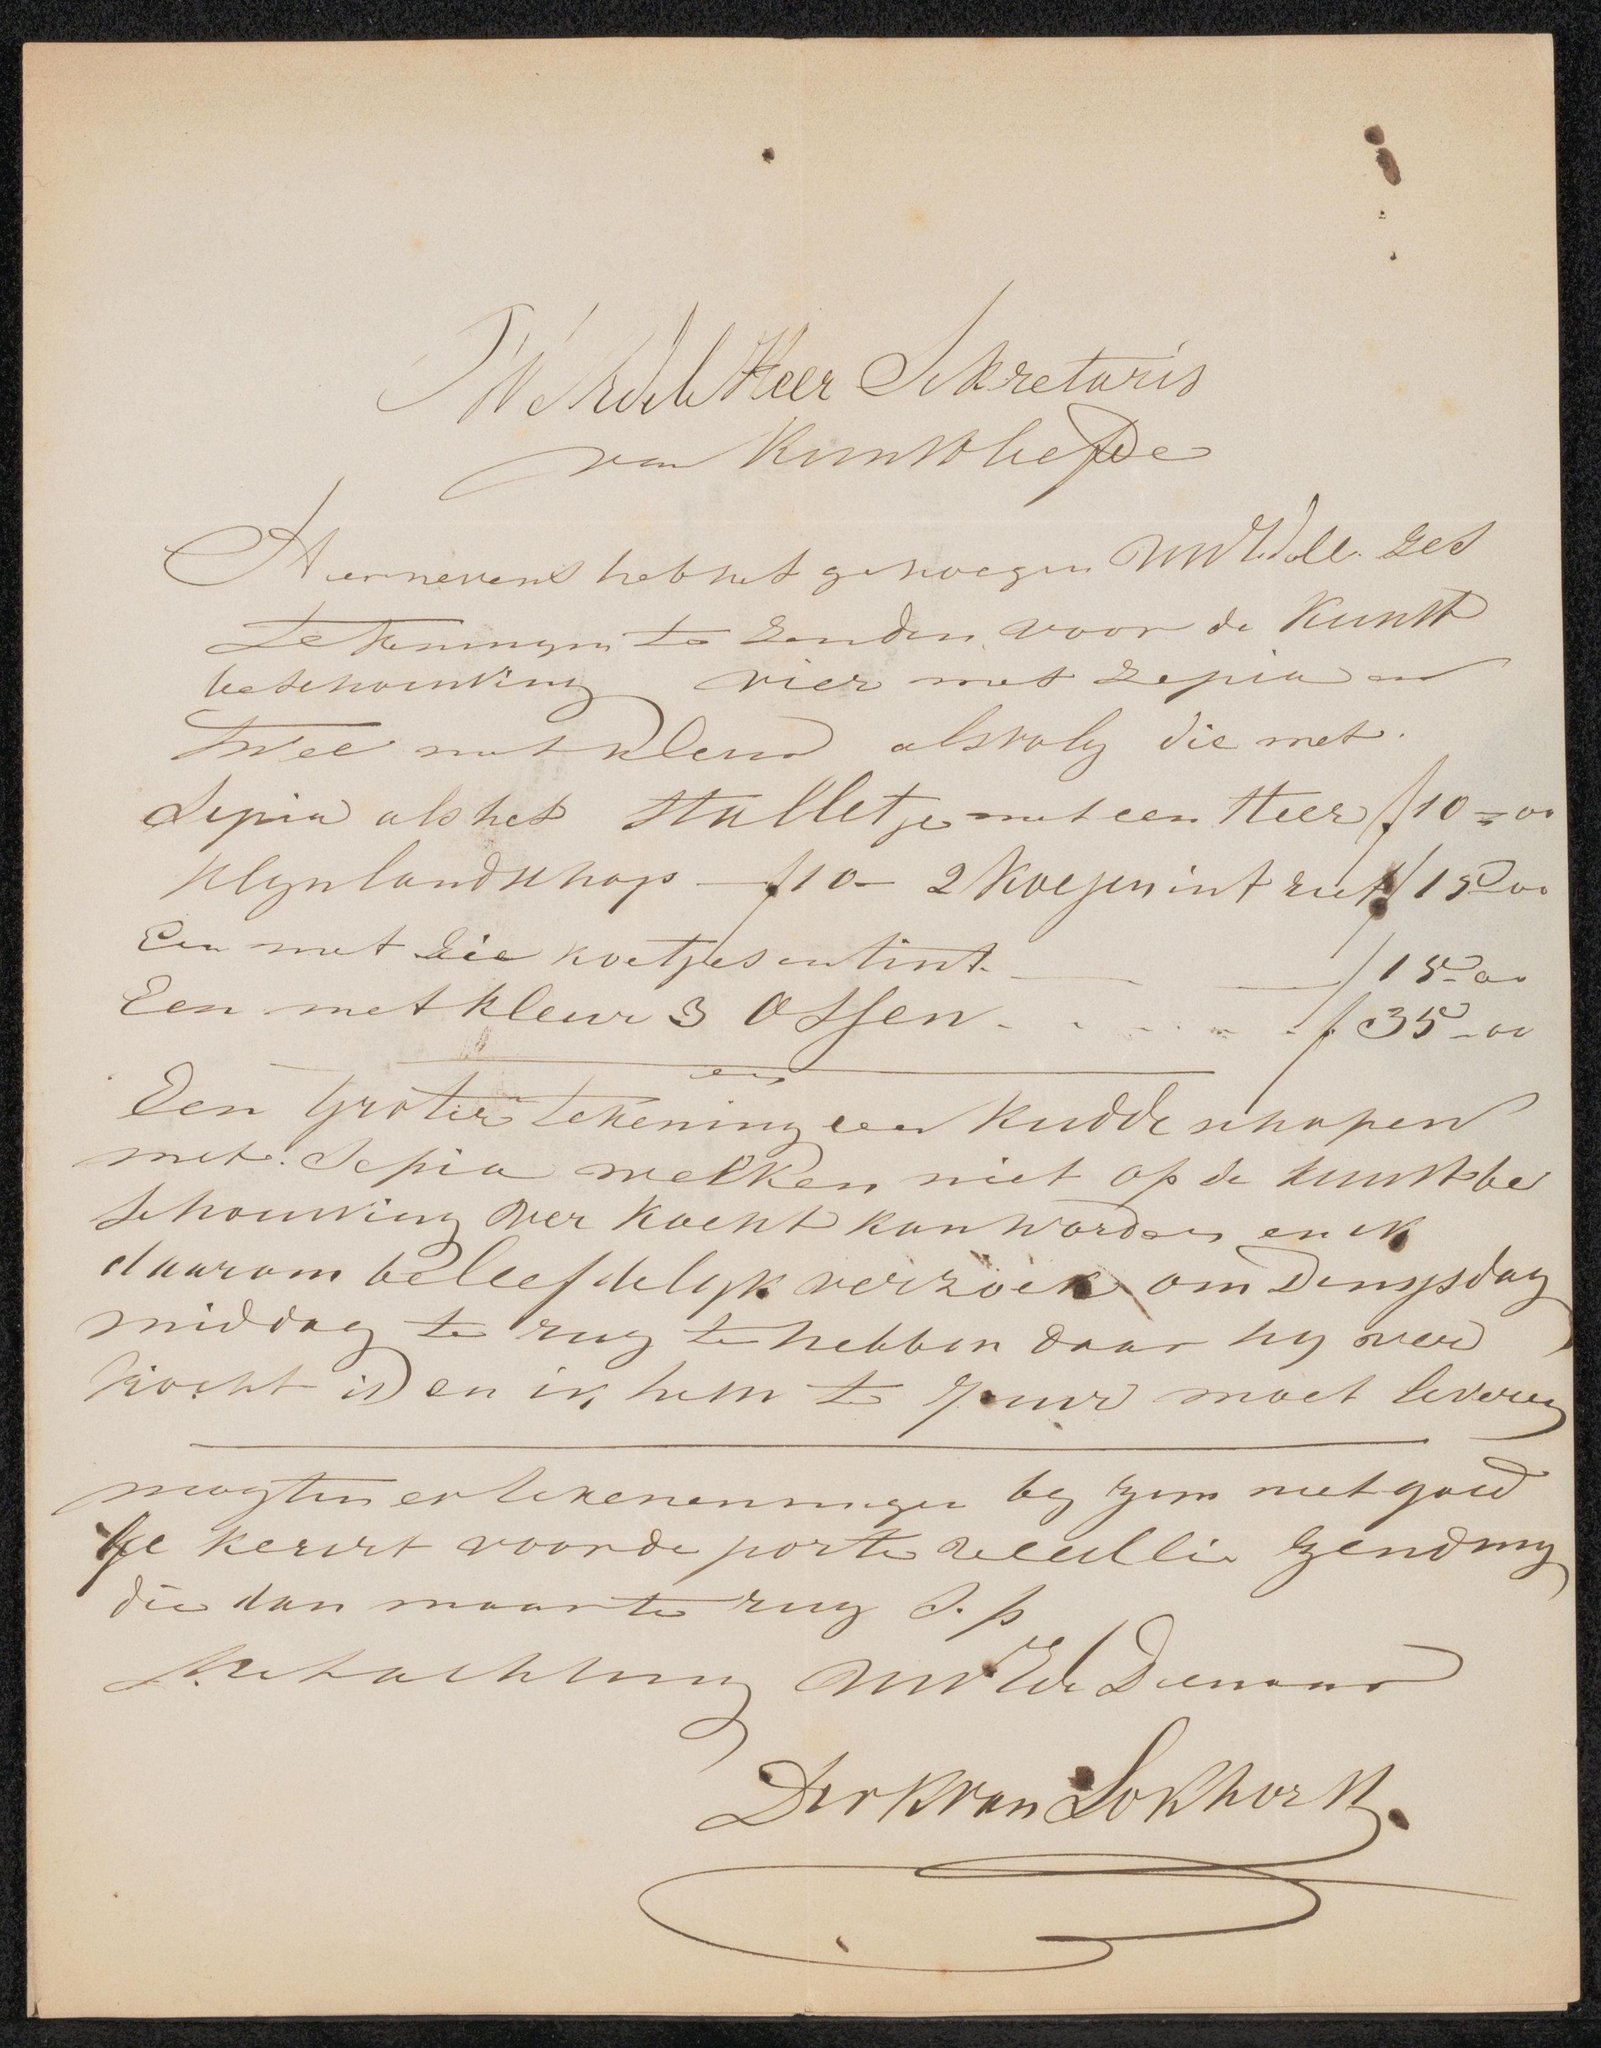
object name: letter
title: Brief aan Pieter Verloren van Themaat, secretaris van Genootschap Kunstliefde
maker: dirk van lokhorst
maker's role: draughtsman, painter, print maker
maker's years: 1818-1893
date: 1840-1885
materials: ink, paper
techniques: pen, writing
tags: pieter verloren van themaat, criticizing and discussing art, art criticism, art trade, art shop, drawing, money